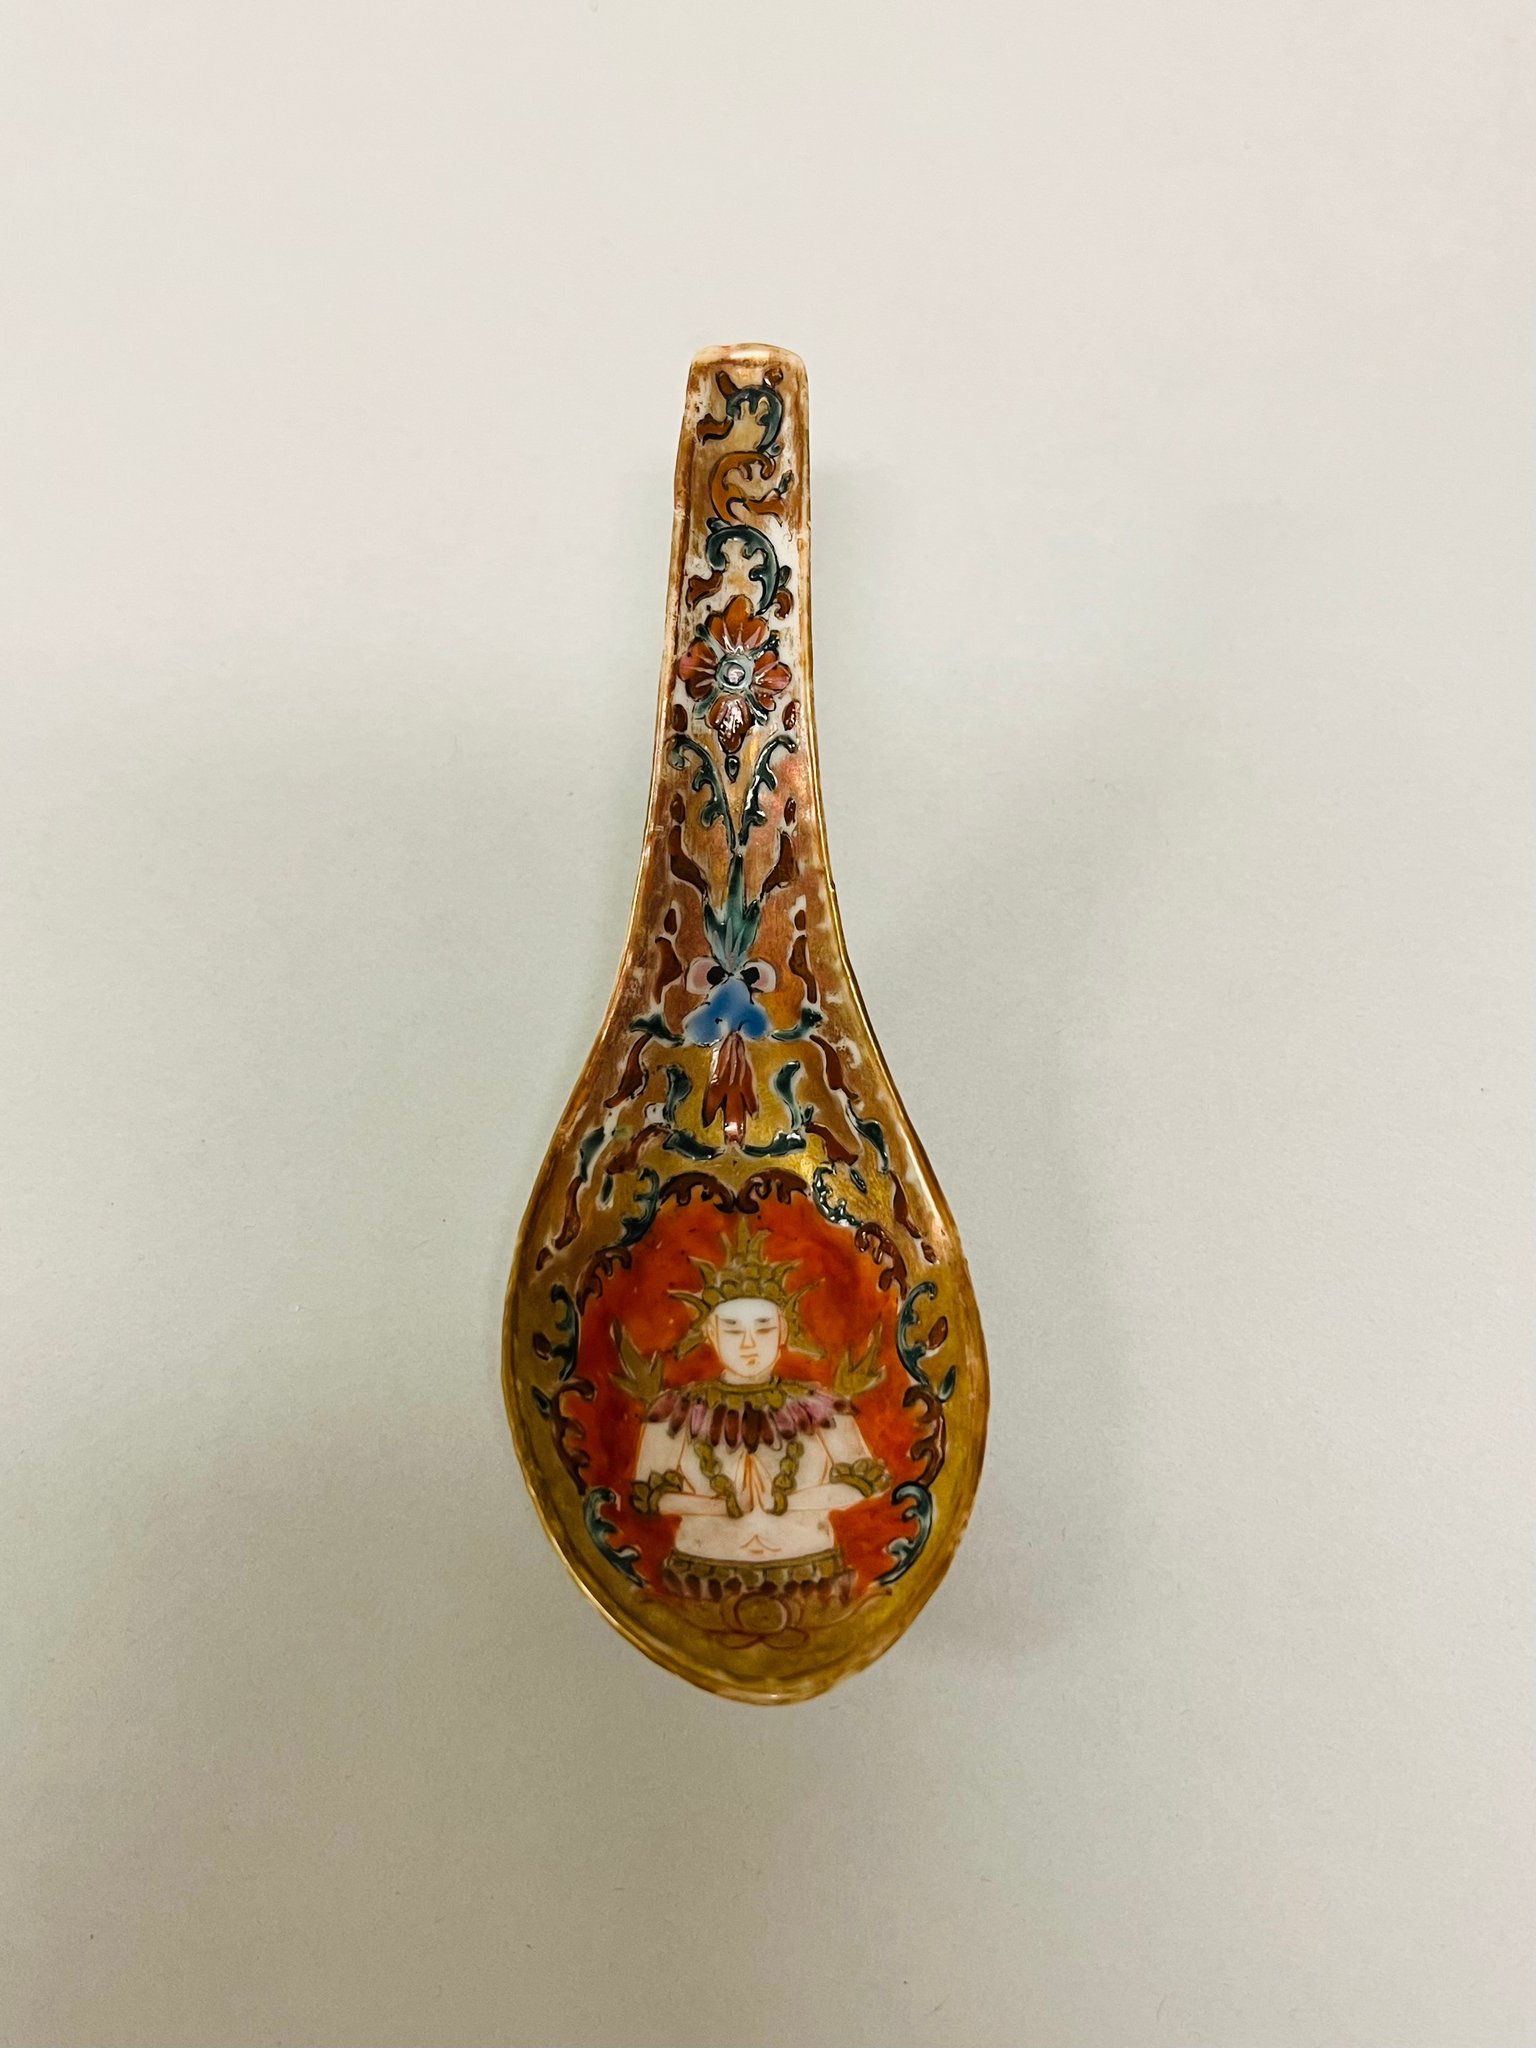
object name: spoon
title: Spoon with Thai mythical figure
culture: chinese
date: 1801-1900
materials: enamel, porcelain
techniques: overglaze, painting, polychrome